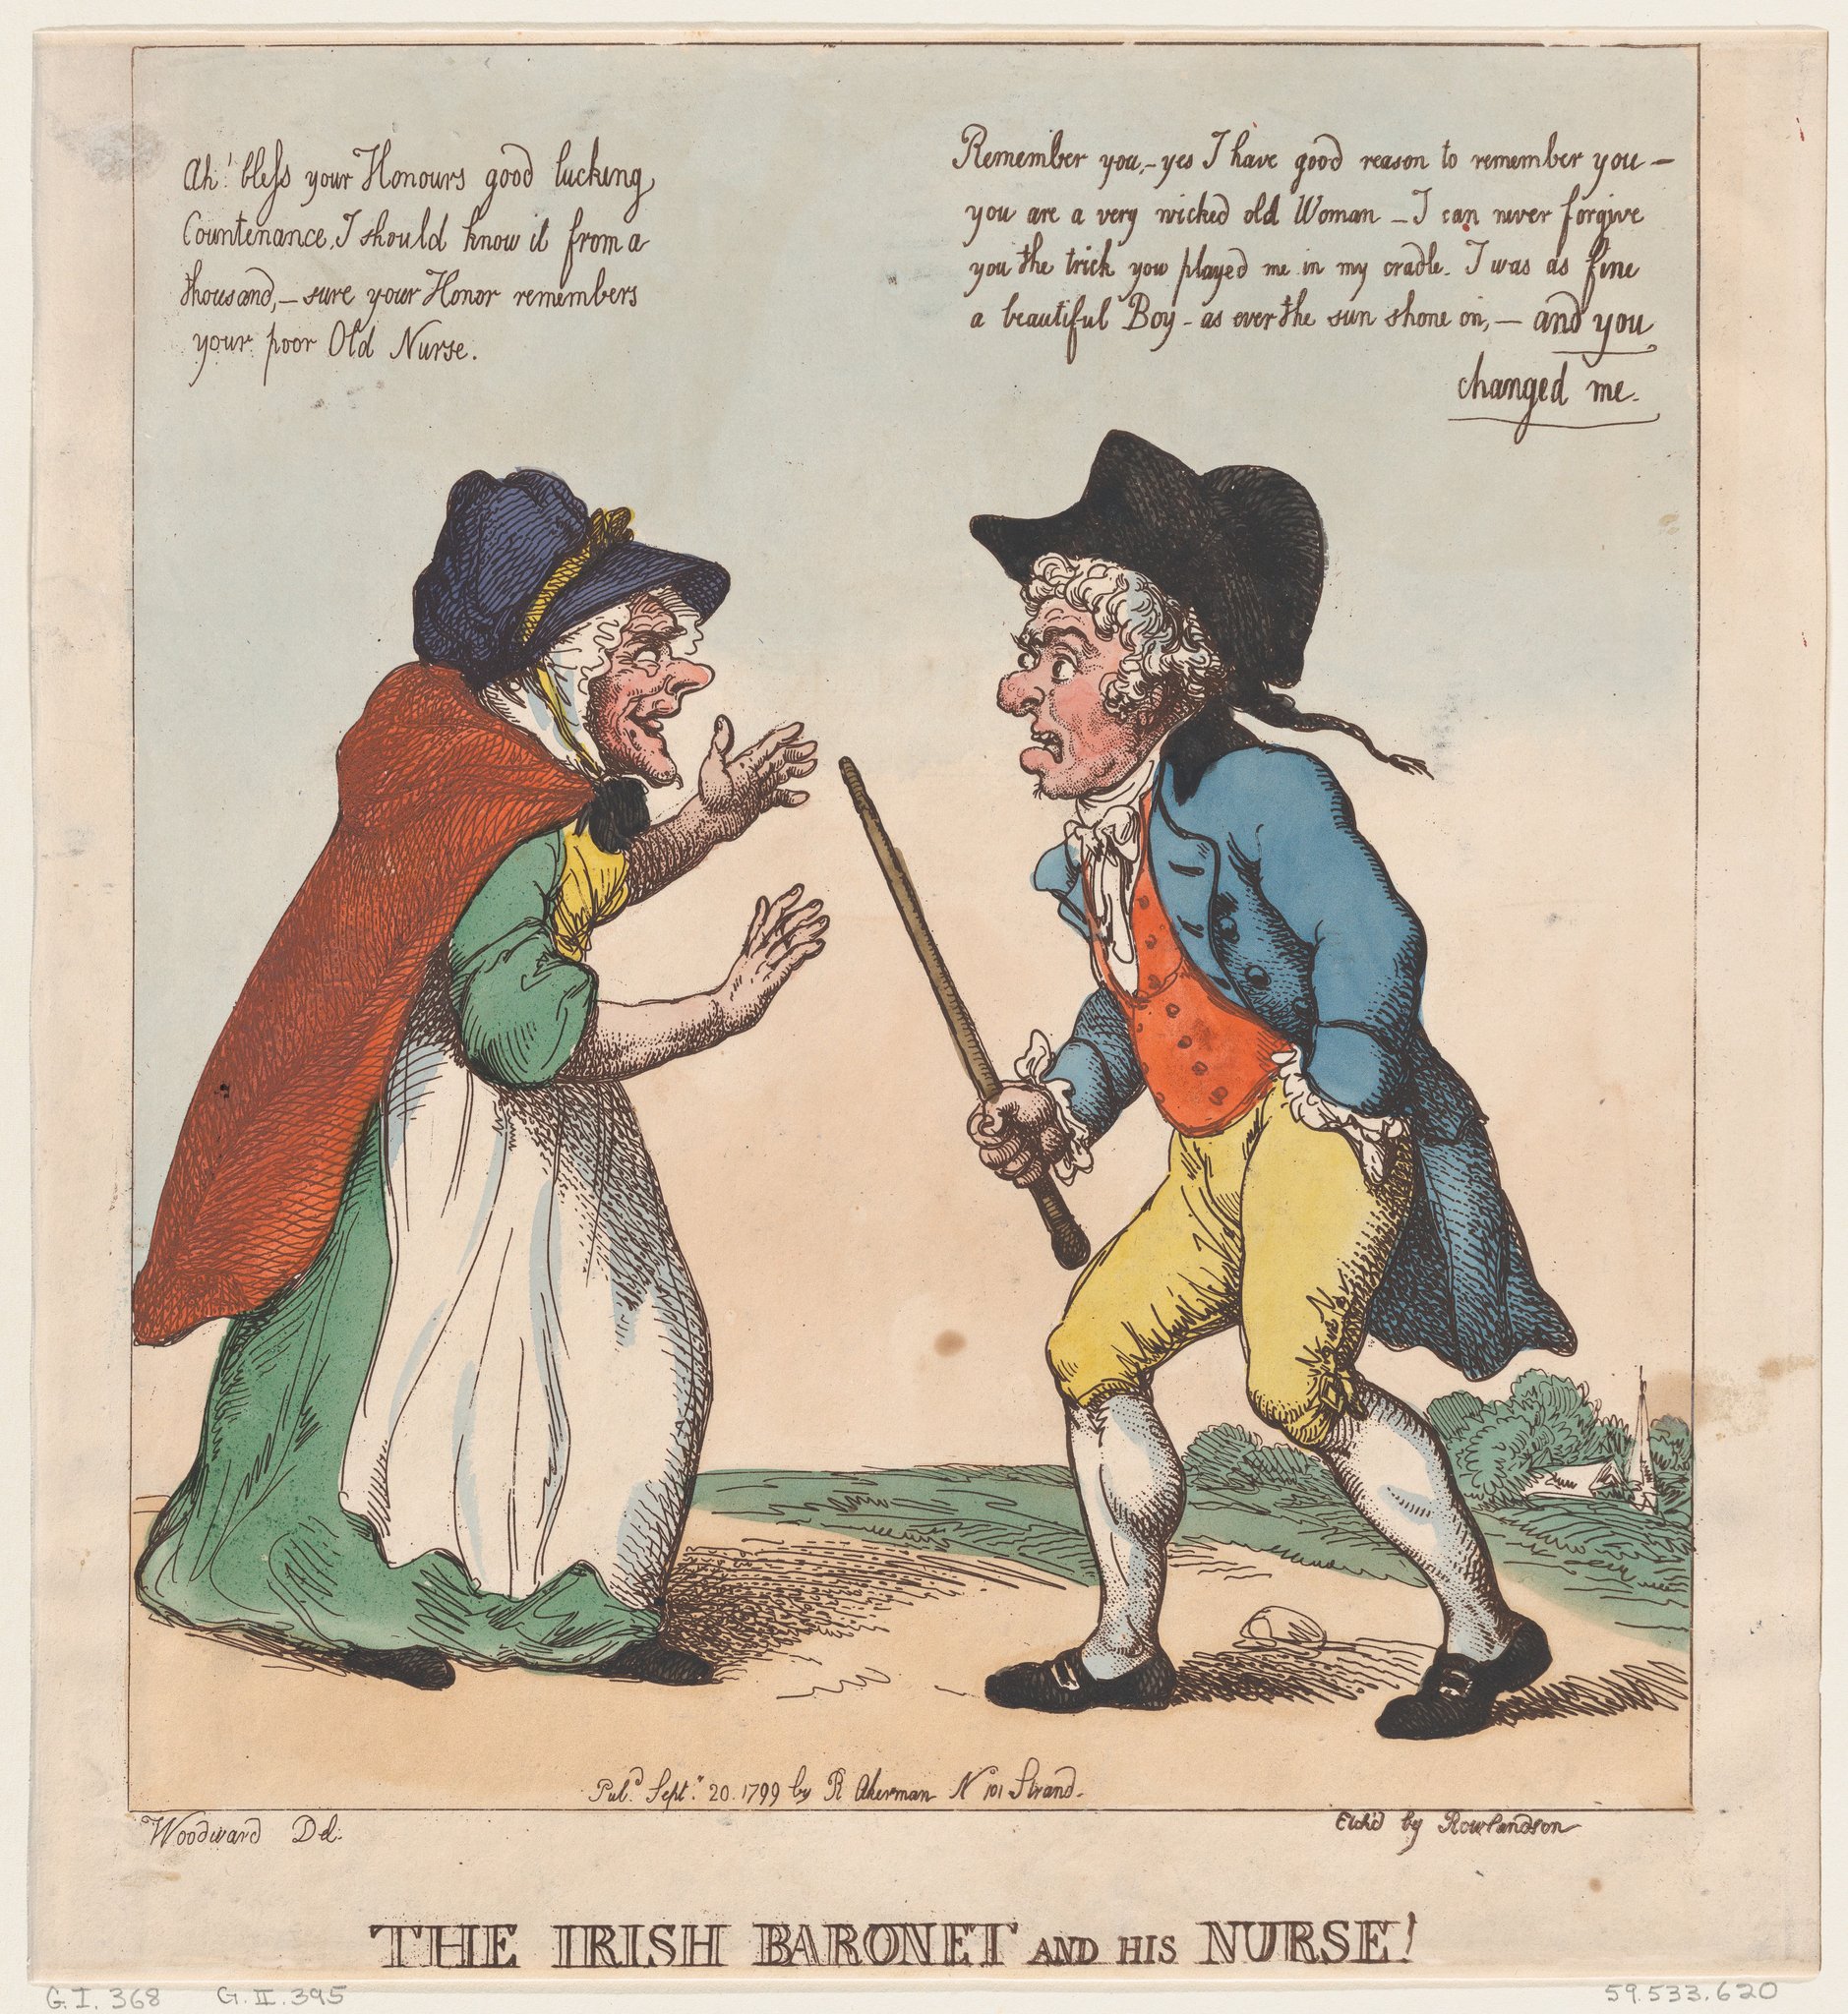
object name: print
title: The Irish Baronet and his Nurse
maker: thomas rowlandson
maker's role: artist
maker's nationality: british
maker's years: 1757-1827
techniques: etching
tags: men,women